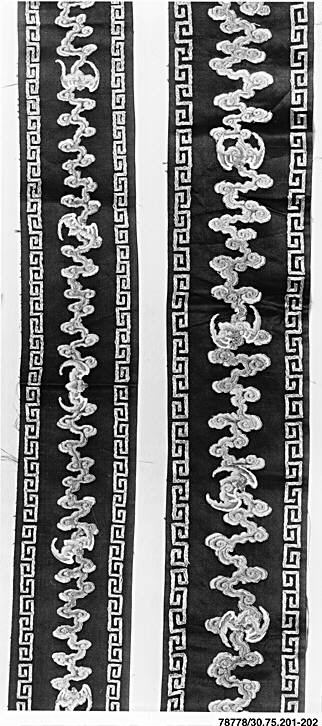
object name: trimming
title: Trimming Bands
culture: chinese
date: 1801-1900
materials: metal thread, silk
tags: bats